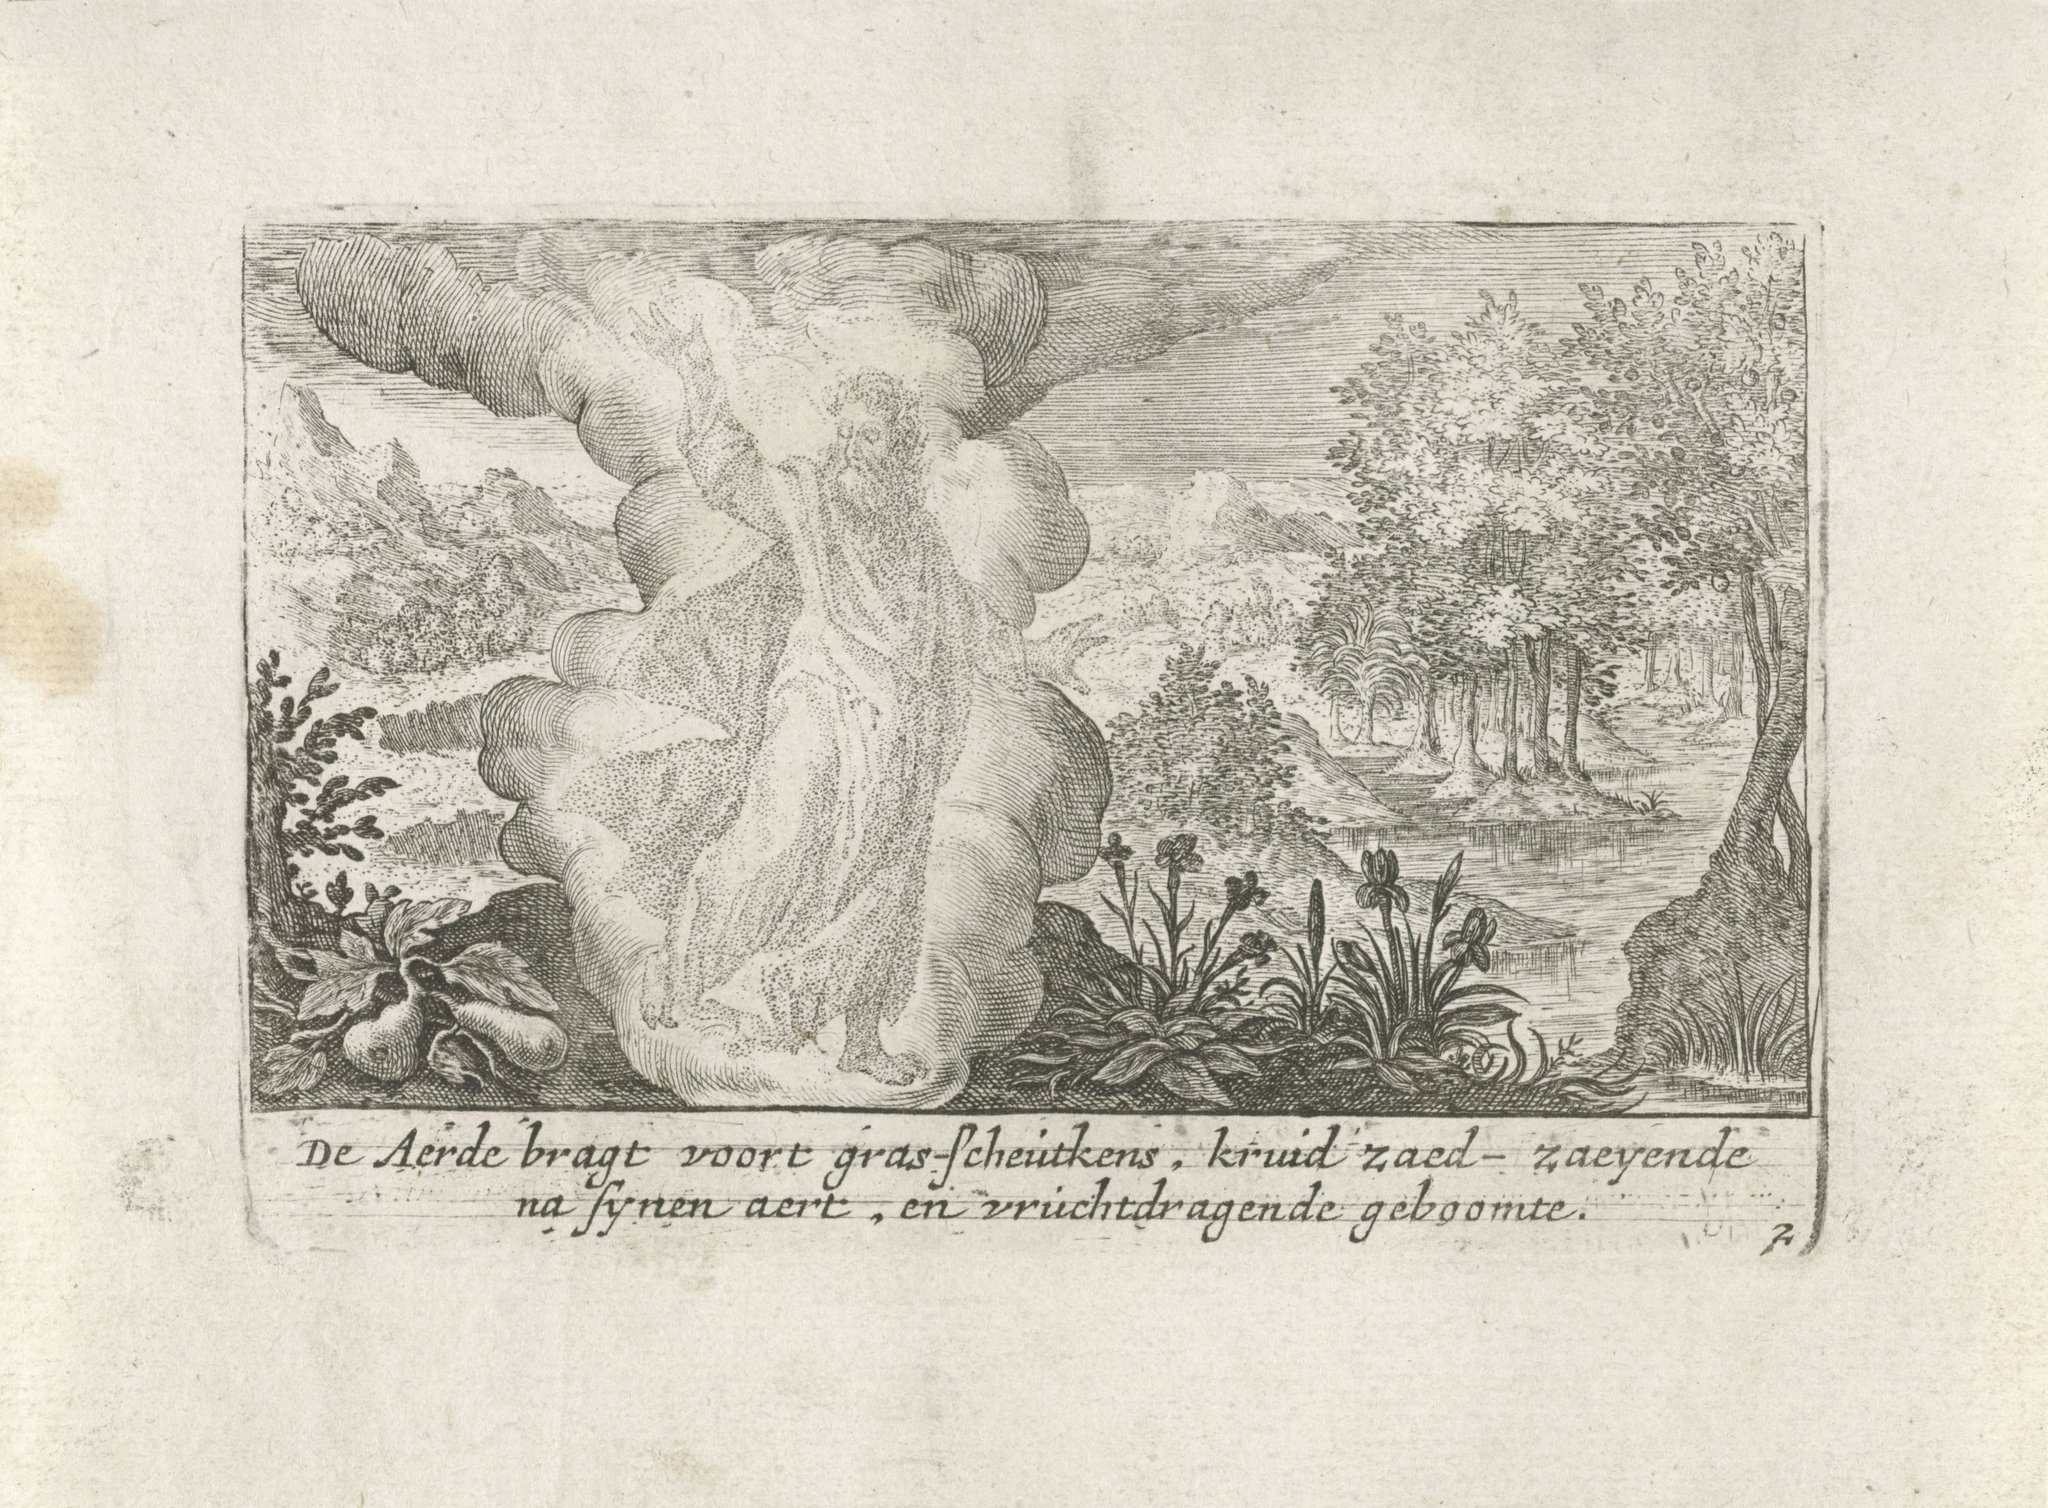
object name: print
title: God schept de droge aarde en de planten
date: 1700-1750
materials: paper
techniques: engraving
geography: amsterdam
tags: gathering of the waters below the firmament; dry land appears and produces all kinds of plants, god the father as young or adult man (perhaps resembling christ)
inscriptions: collector's mark: Lugt 2233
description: God schept het land, de zaadvormende planten en de bomen met vruchten die zaden dragen. Het water trekt zich terug in rivieren en de zee. In de marge een tweeregelig onderschrift in het Nederlands.